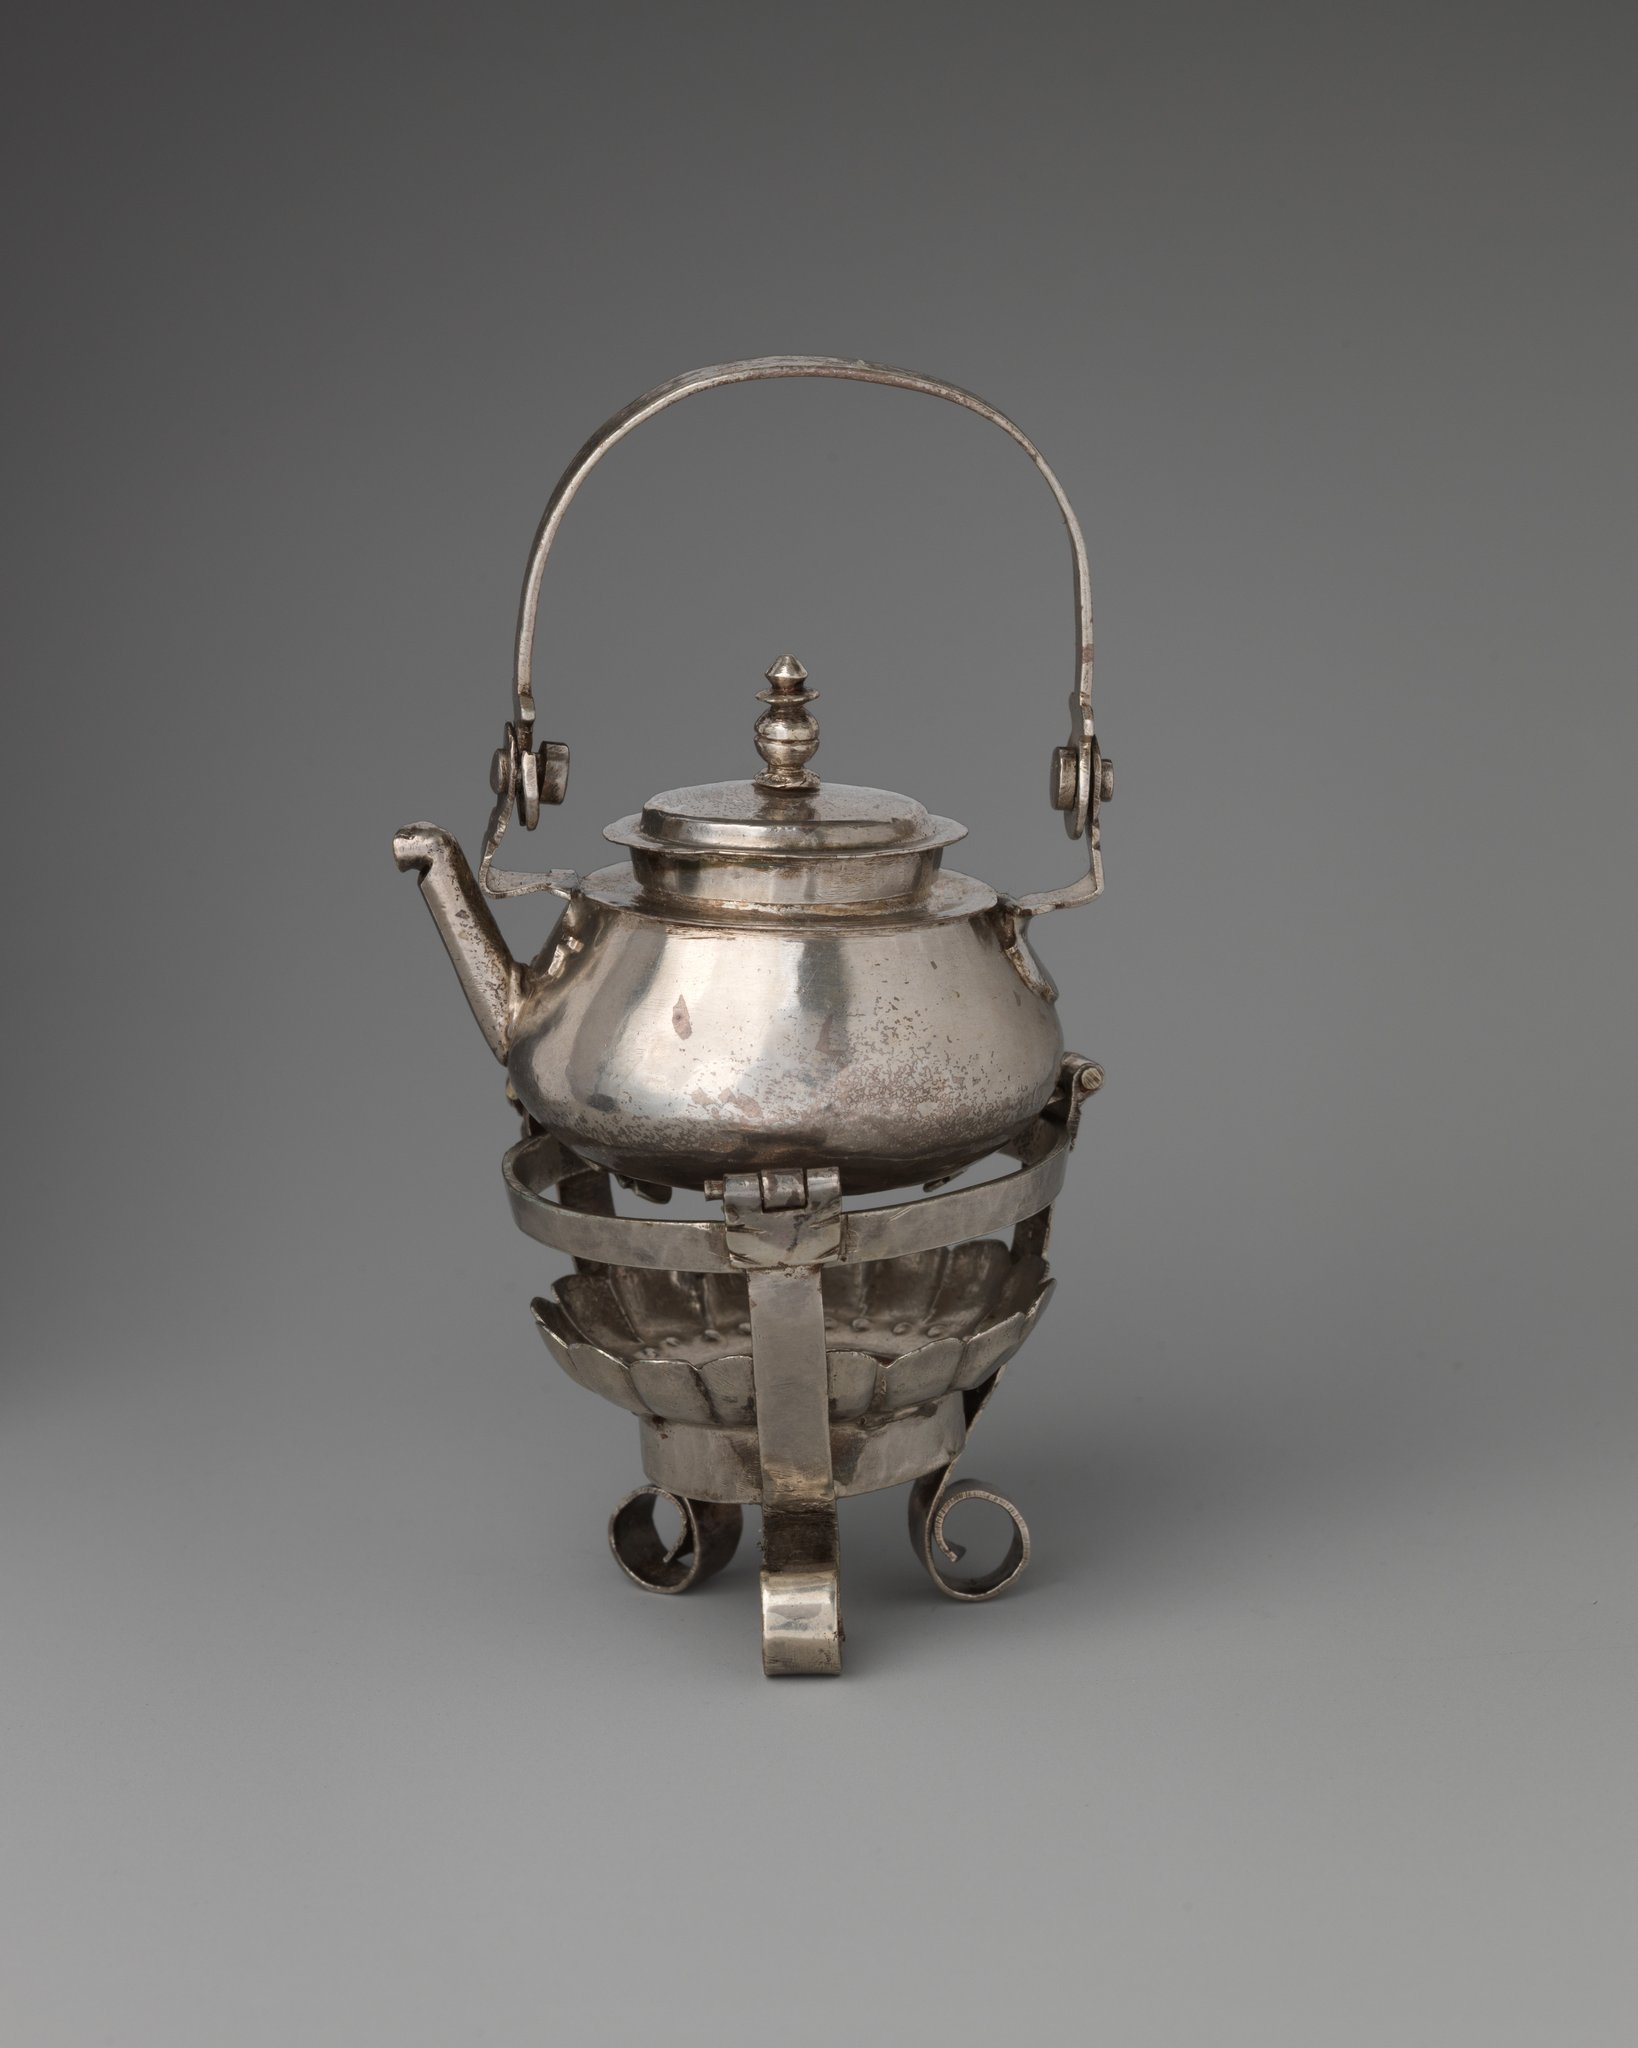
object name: kettle with cover and brazier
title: Miniature kettle with cover and brazier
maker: george manjoy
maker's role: maker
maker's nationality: british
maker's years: 1685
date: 1713-1714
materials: silver